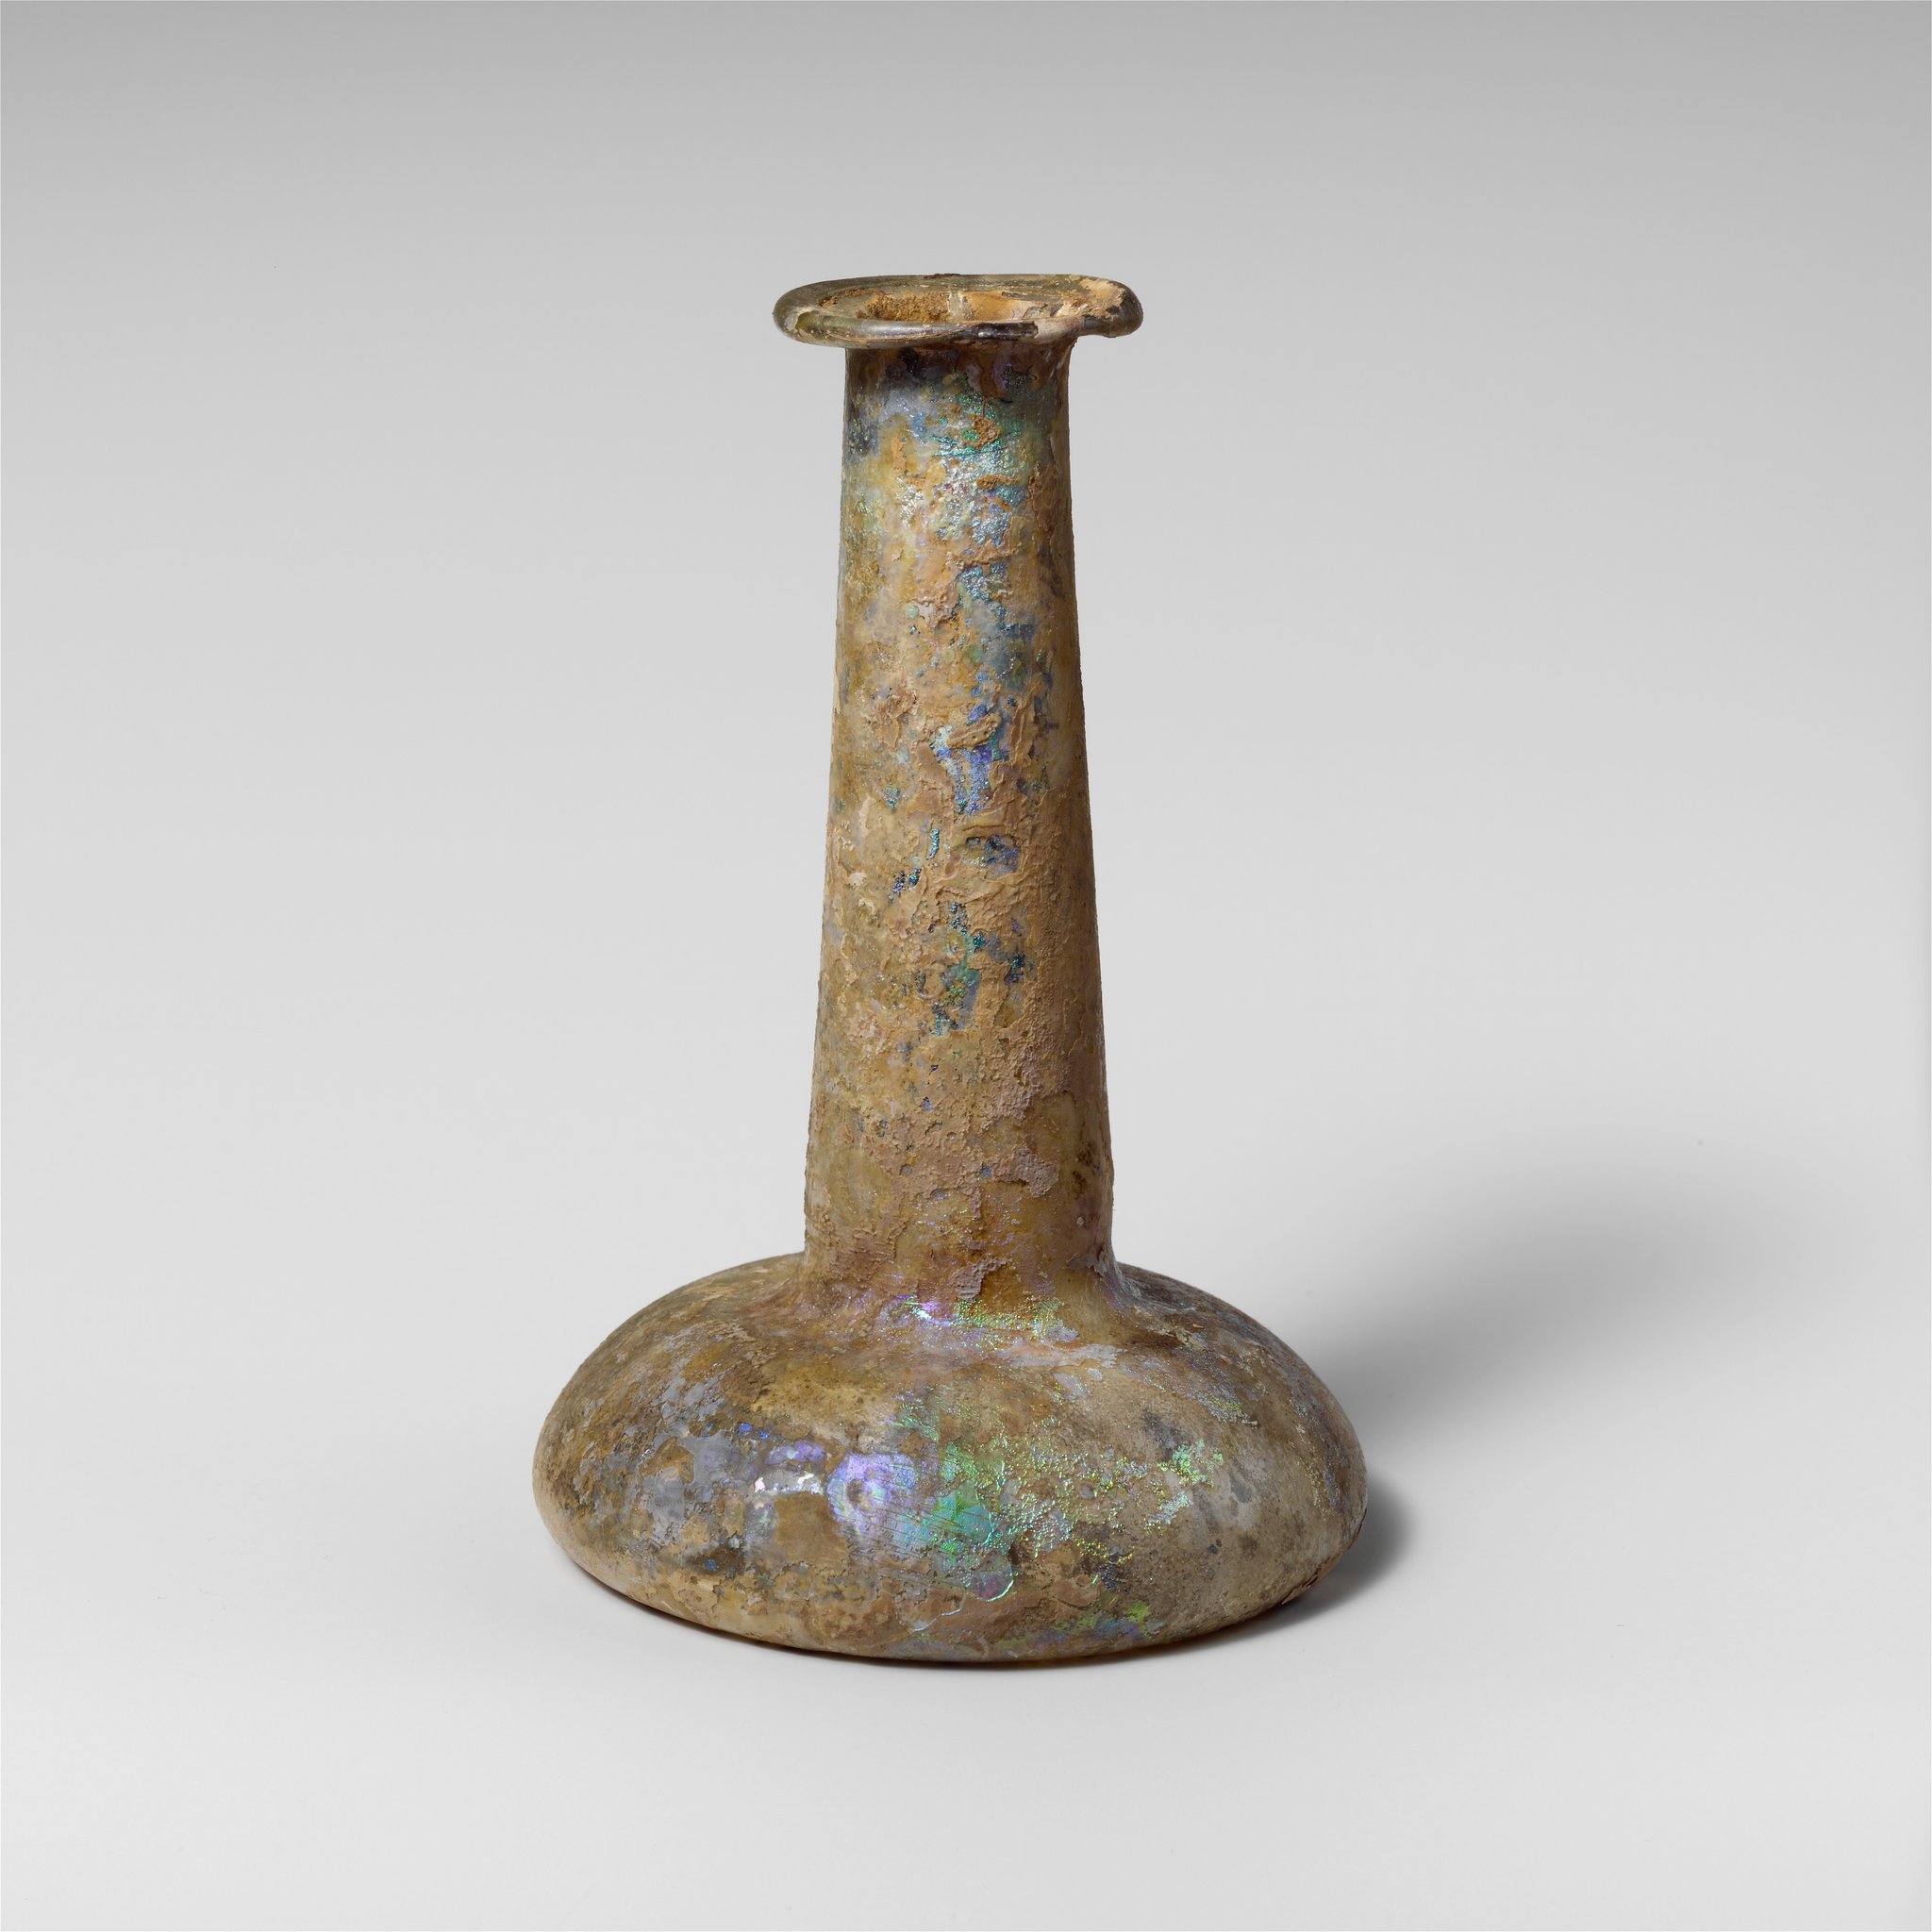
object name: perfume bottle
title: Glass perfume bottle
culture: roman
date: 101-300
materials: glass